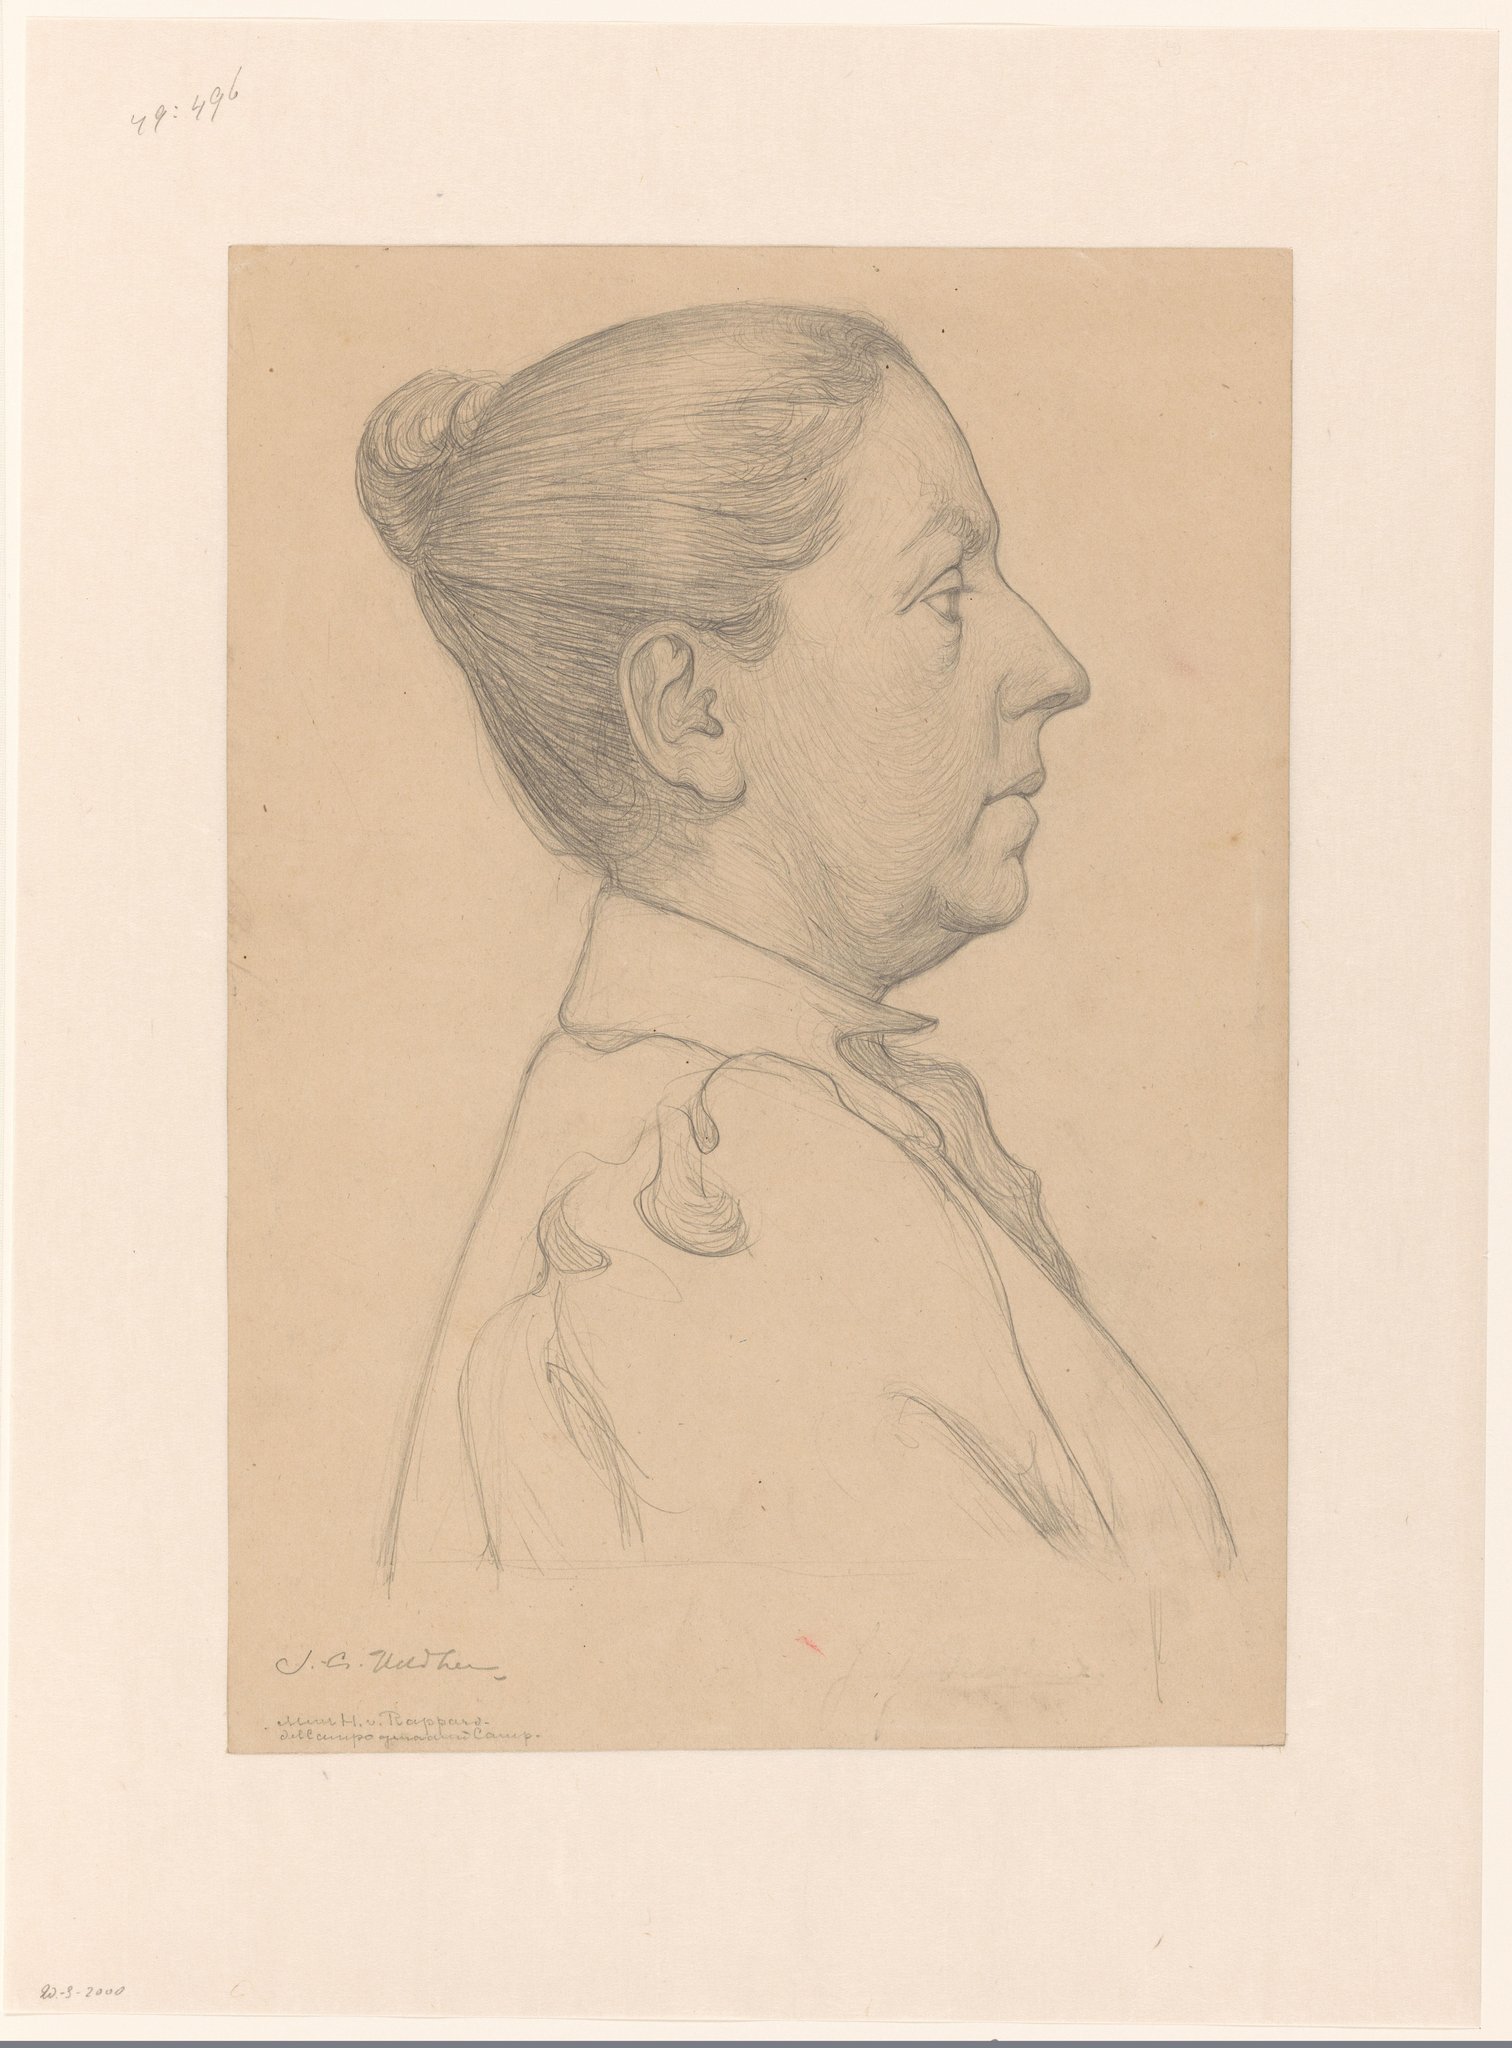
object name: drawing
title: Mevrouw H. van Rappard-DelCampo genaamd Camp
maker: jacobus gerardus veldheer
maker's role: draughtsman, print maker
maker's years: 1866-1954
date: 1876-1949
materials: paper, pencil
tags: the hague, henriëtte elisabeth rappard-del campo genaamd camp, historical persons - bb - woman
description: Voorstudie voor portret van Mevrouw H. van Rappard-DelCampo genaamd Camp.